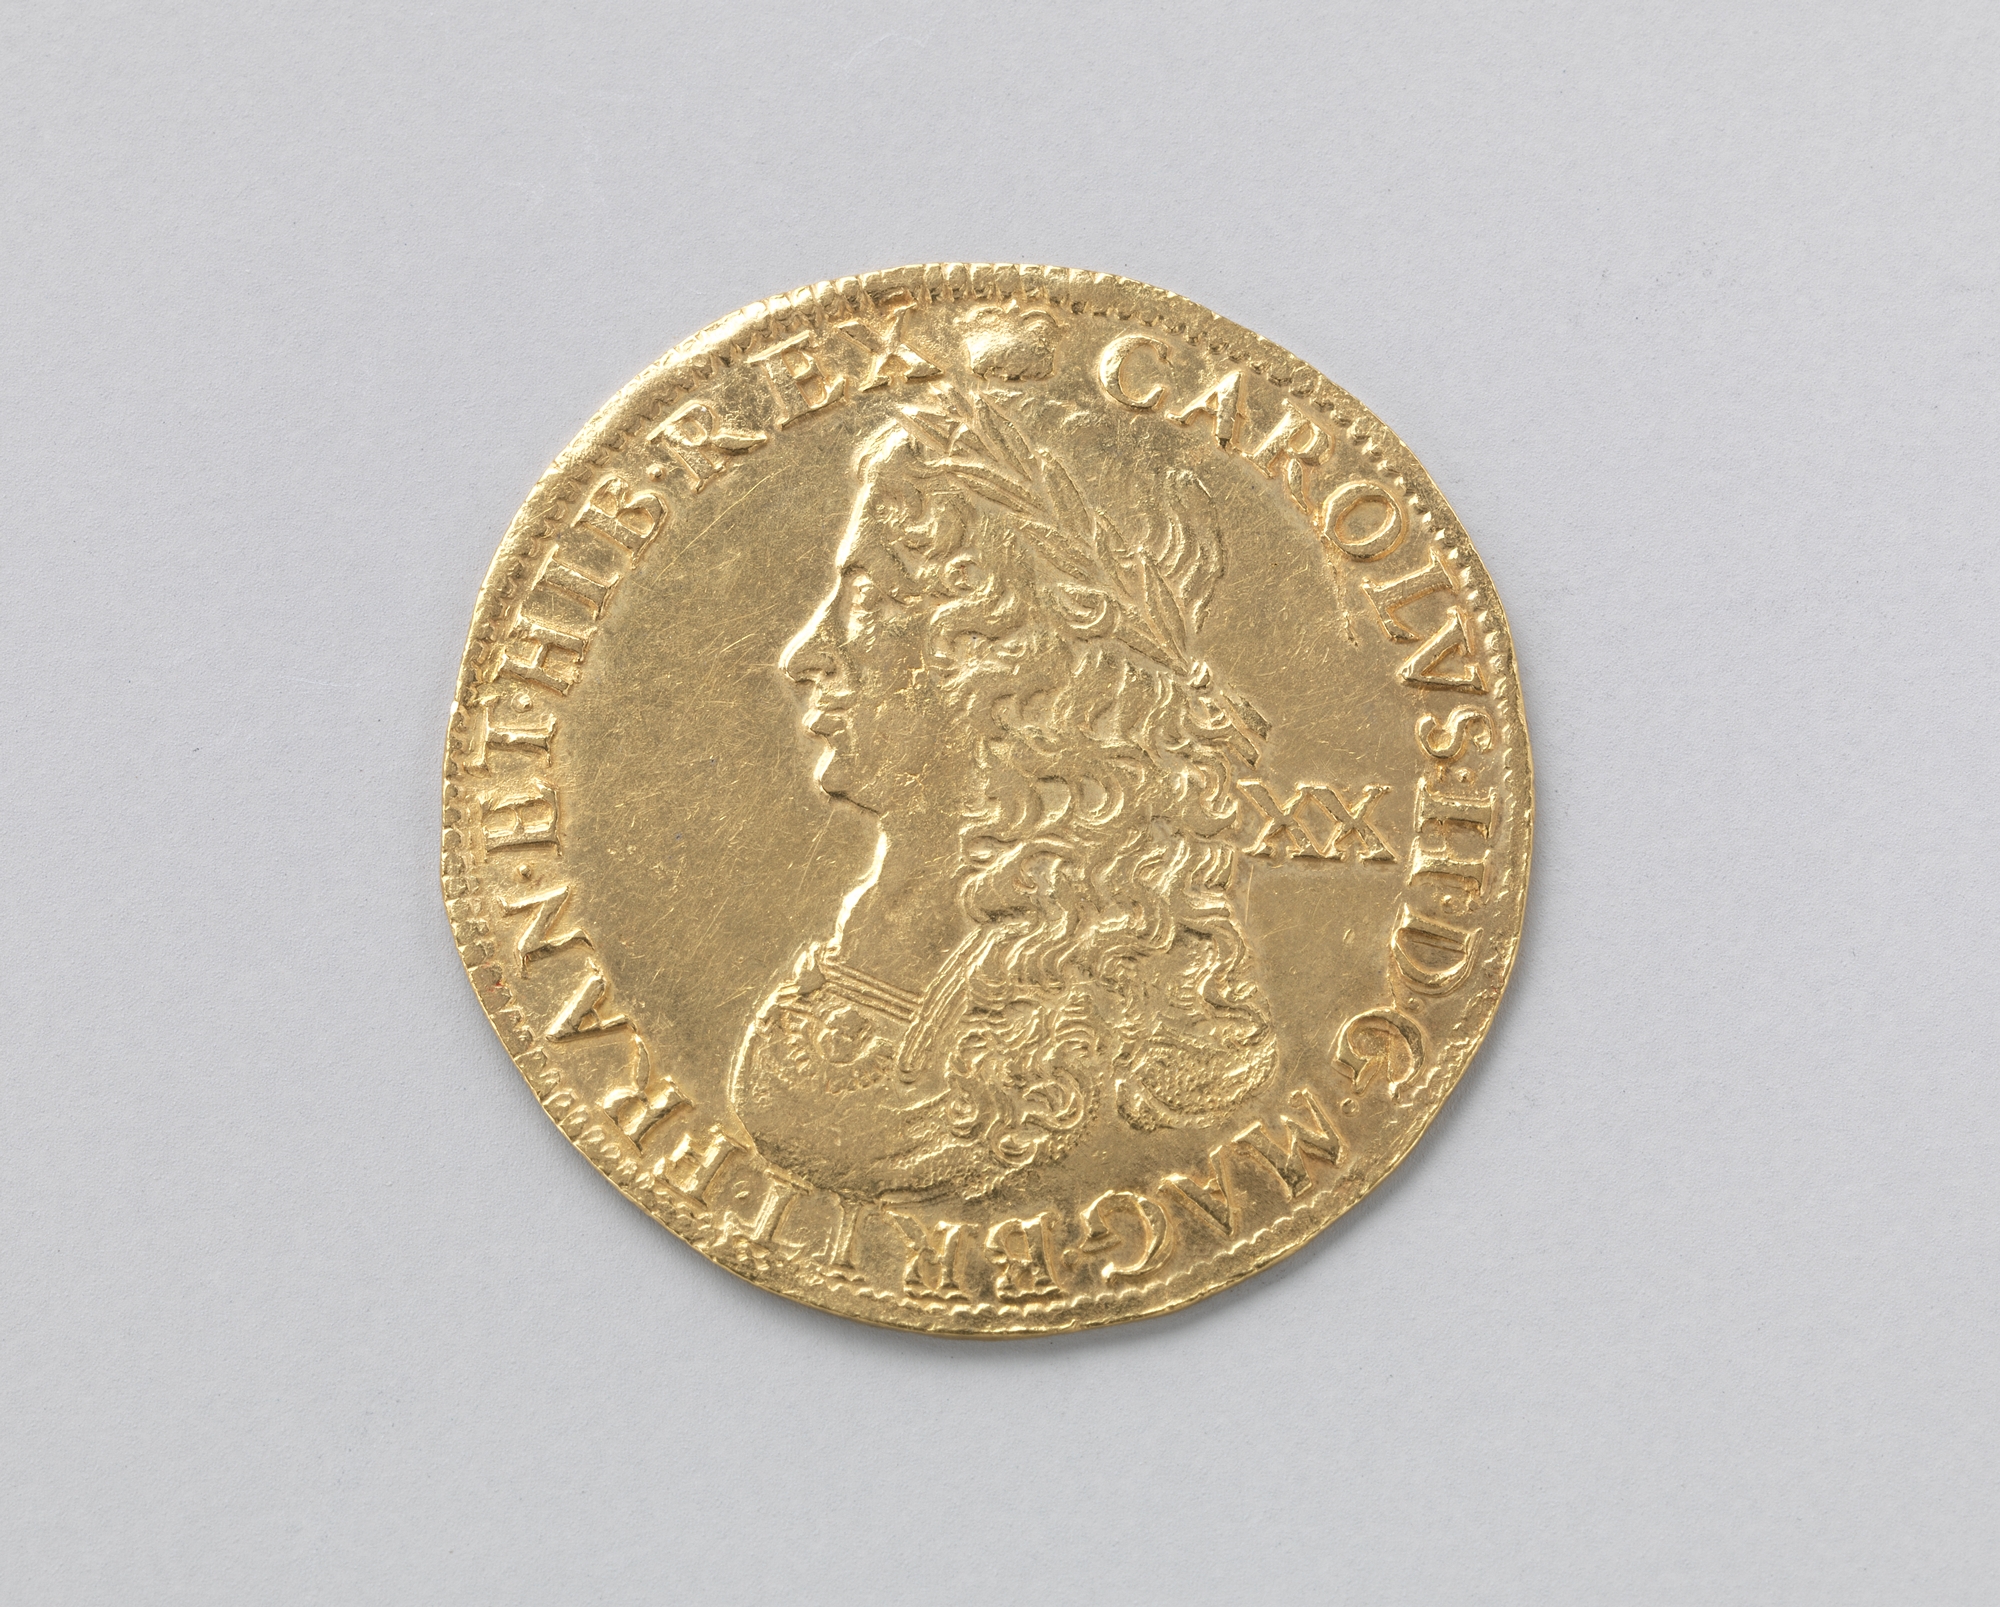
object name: double crown coin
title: Charles II (r. 1660–85)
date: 1661-1662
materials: gold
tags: men,profiles